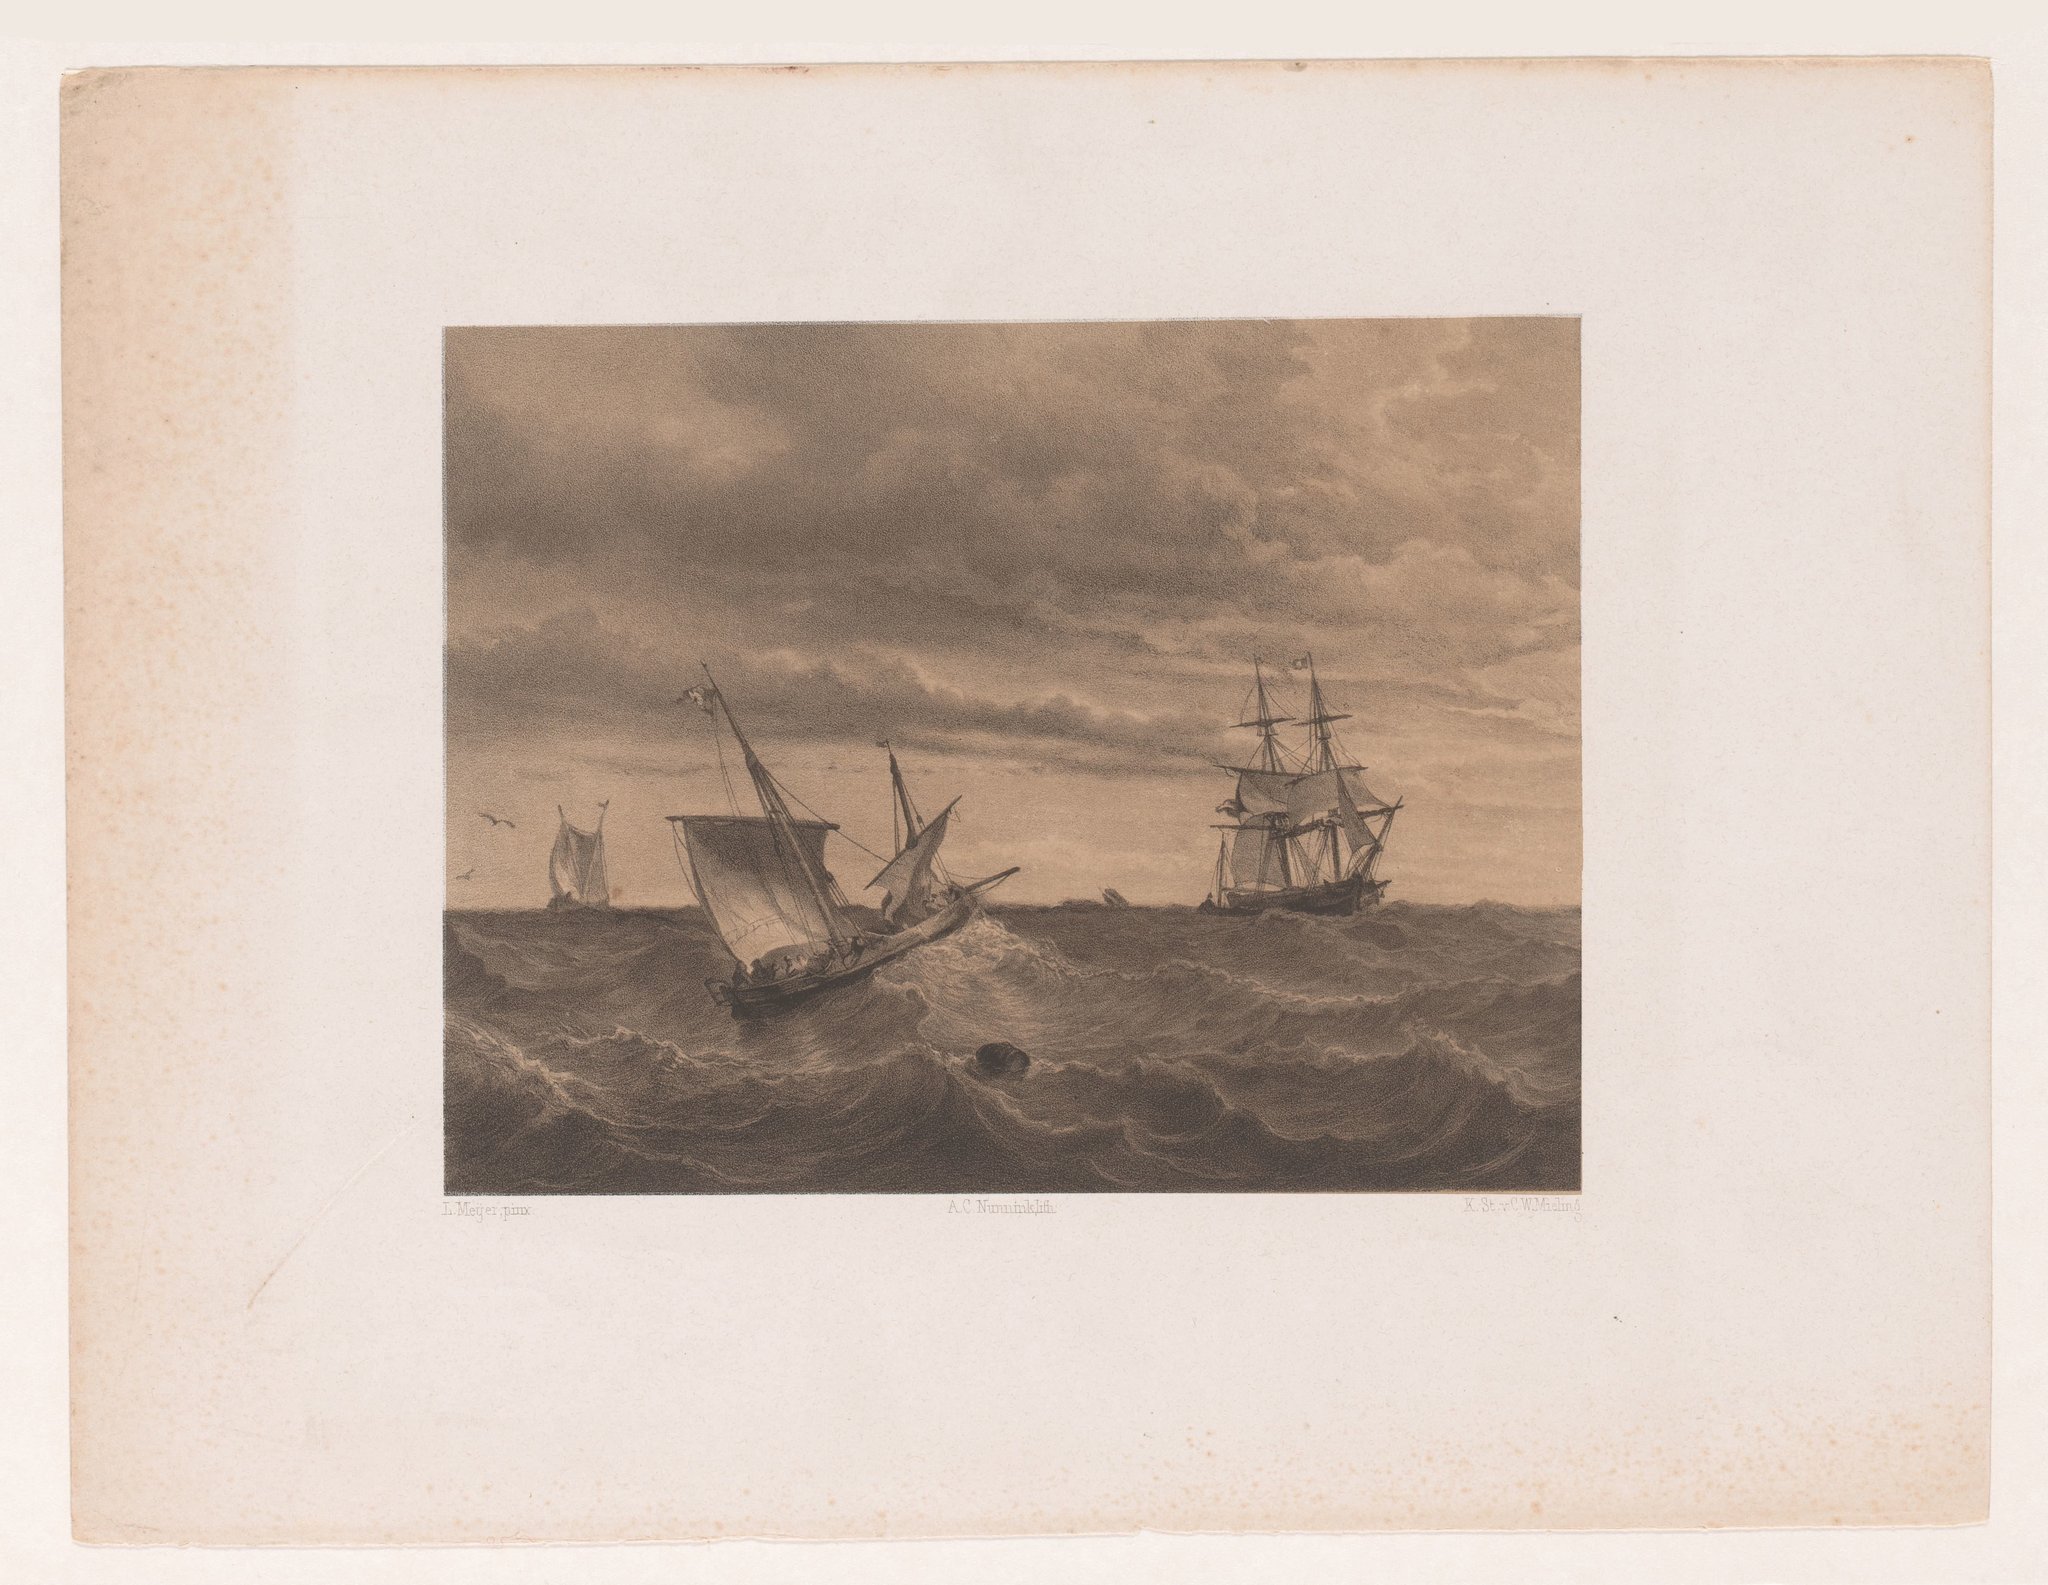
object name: print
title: Zeilboten op wilde zee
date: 1847-1865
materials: paper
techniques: tone lithography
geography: the hague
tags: sailing-ship, sailing-boat, sea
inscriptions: collector's mark: Lugt 2228